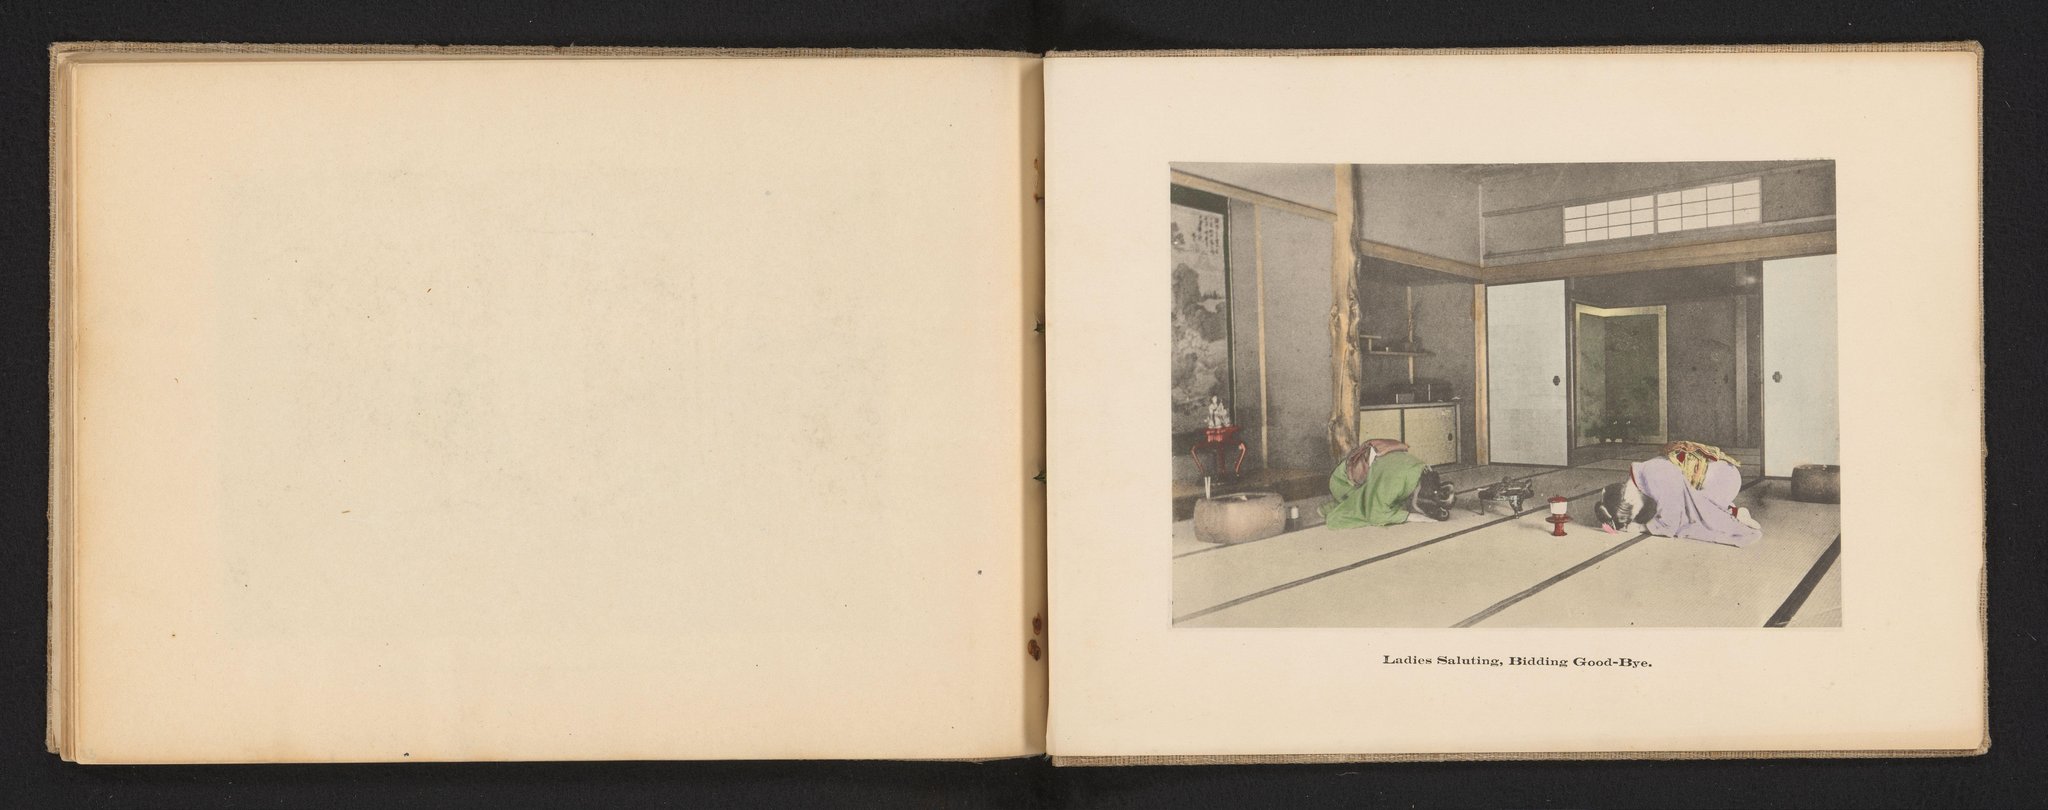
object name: photomechanical print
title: Twee Japanse vrouwen die elkaar knielend begroeten in een huis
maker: kōzaburō tamamura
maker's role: fotograaf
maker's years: 1856-1923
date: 1895-1905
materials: paper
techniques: photograph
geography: japan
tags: saluting, japan